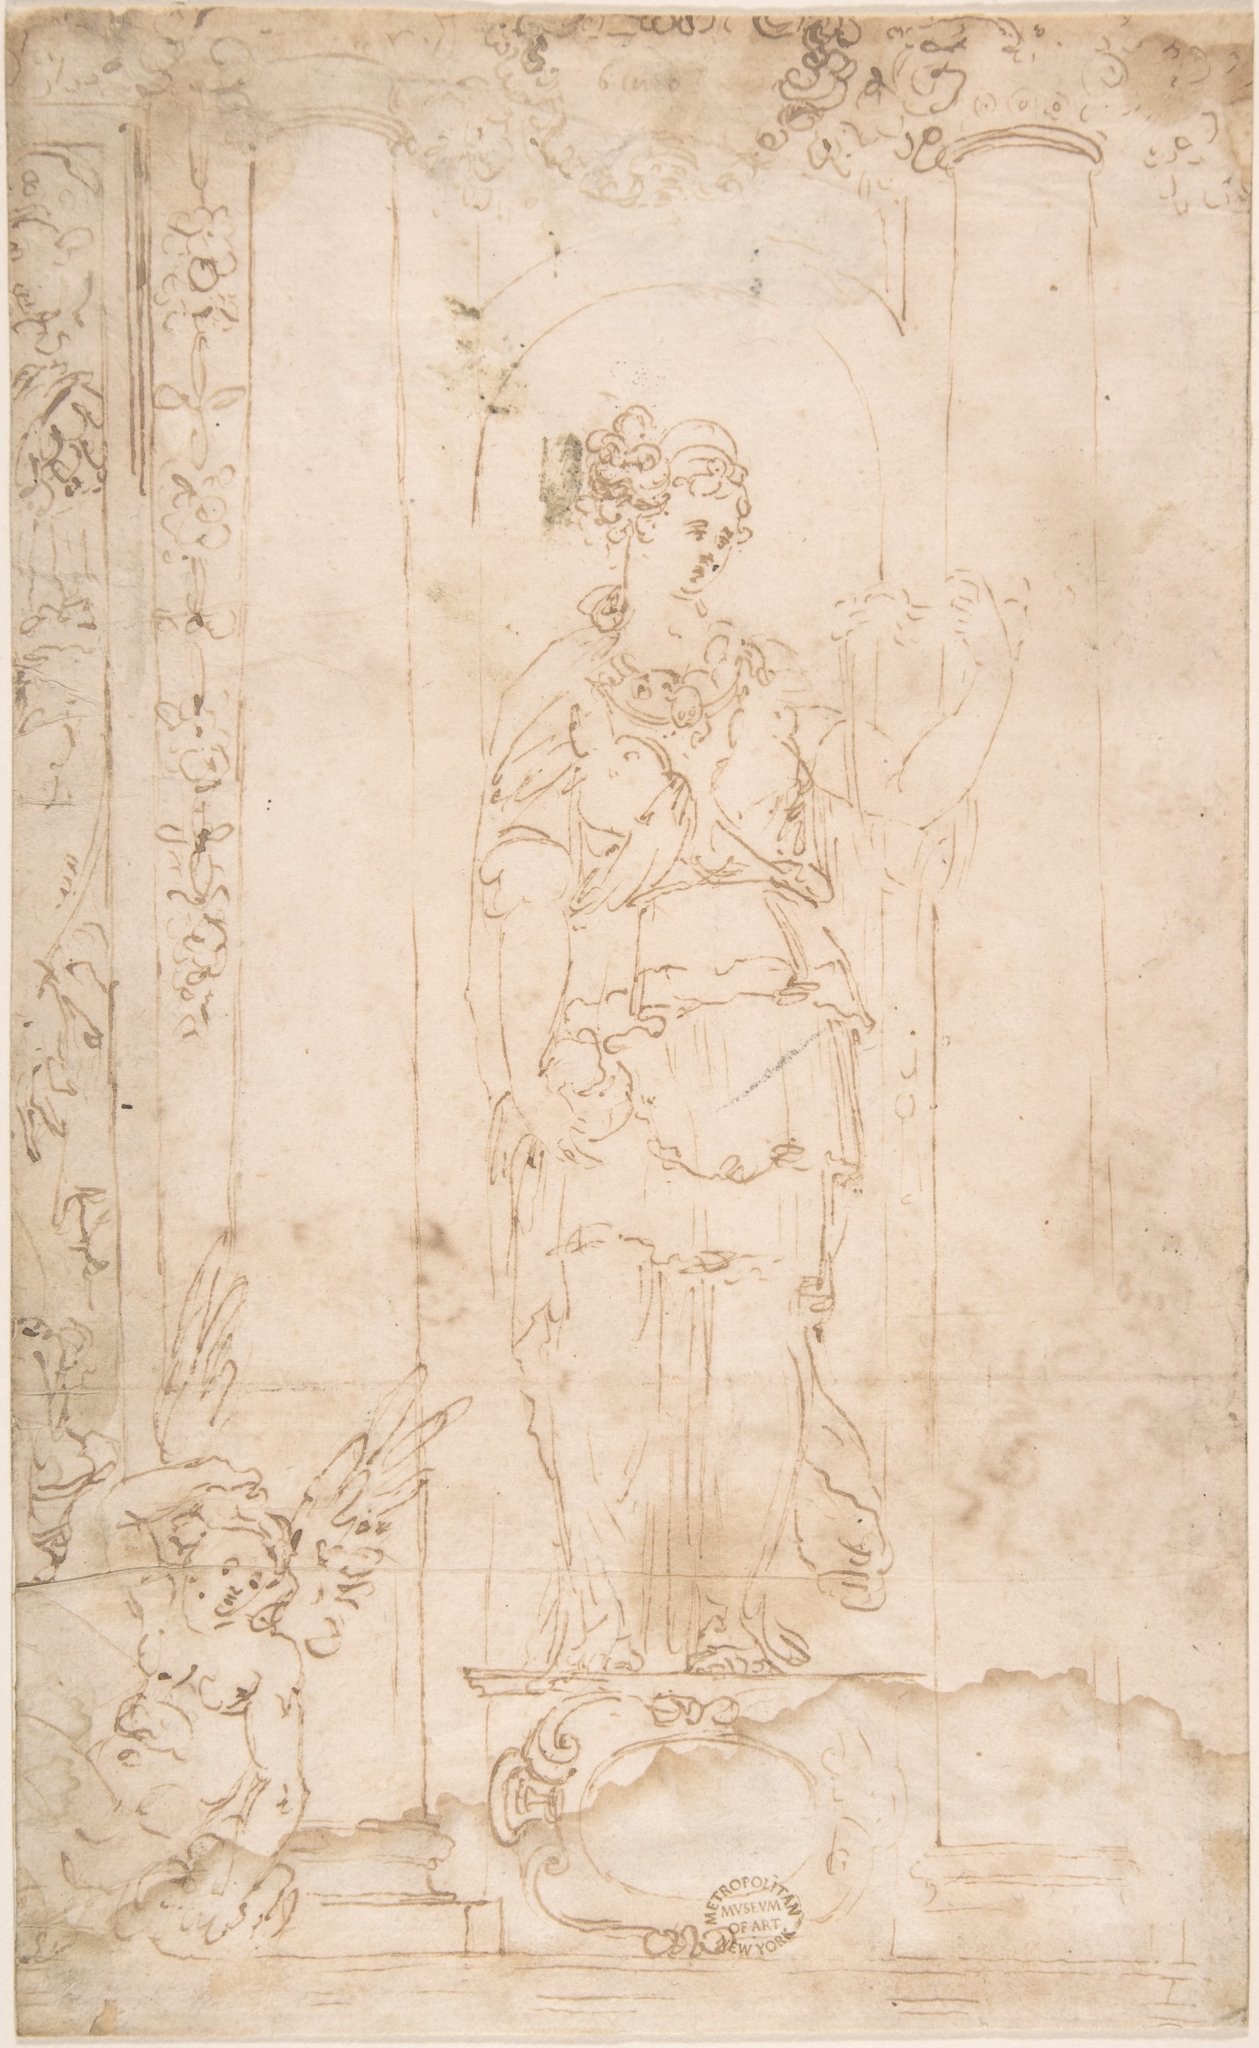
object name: drawing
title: Allegory or Goddess (Juno?)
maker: perino del vaga (pietro buonaccorsi)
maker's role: artist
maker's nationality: italian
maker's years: 1501-1547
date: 1501-1600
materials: ink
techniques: pen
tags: women,goddess